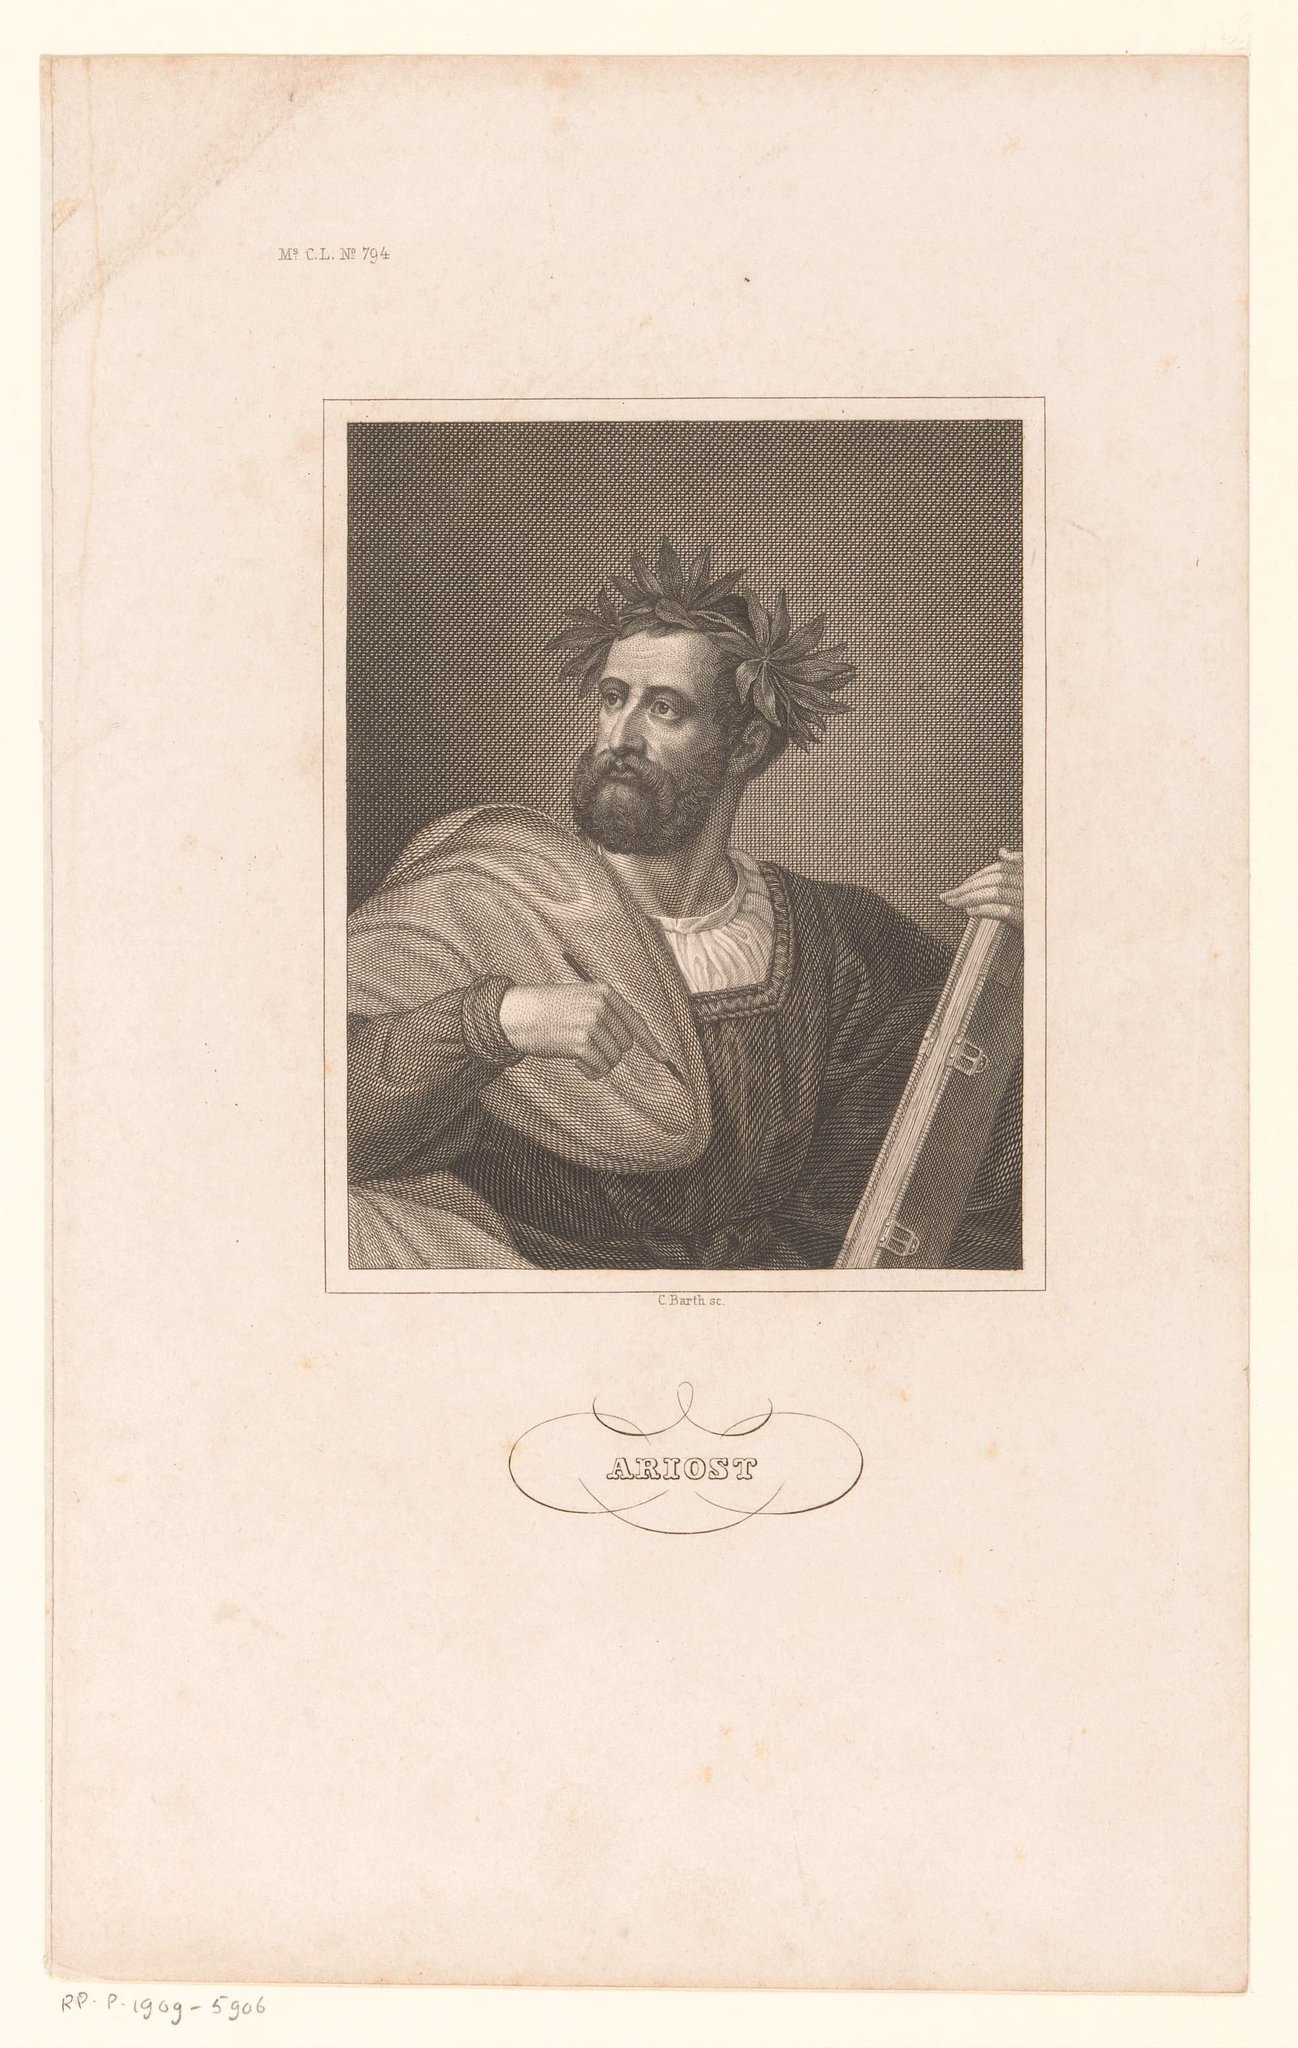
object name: print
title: Portret van Ludovico Ariosto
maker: karl barth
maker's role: print maker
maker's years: 1787-1853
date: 1828-1853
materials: paper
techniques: engraving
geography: hildburghausen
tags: ludovico ariosto, historical persons, book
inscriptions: collector's mark: Lugt 2228